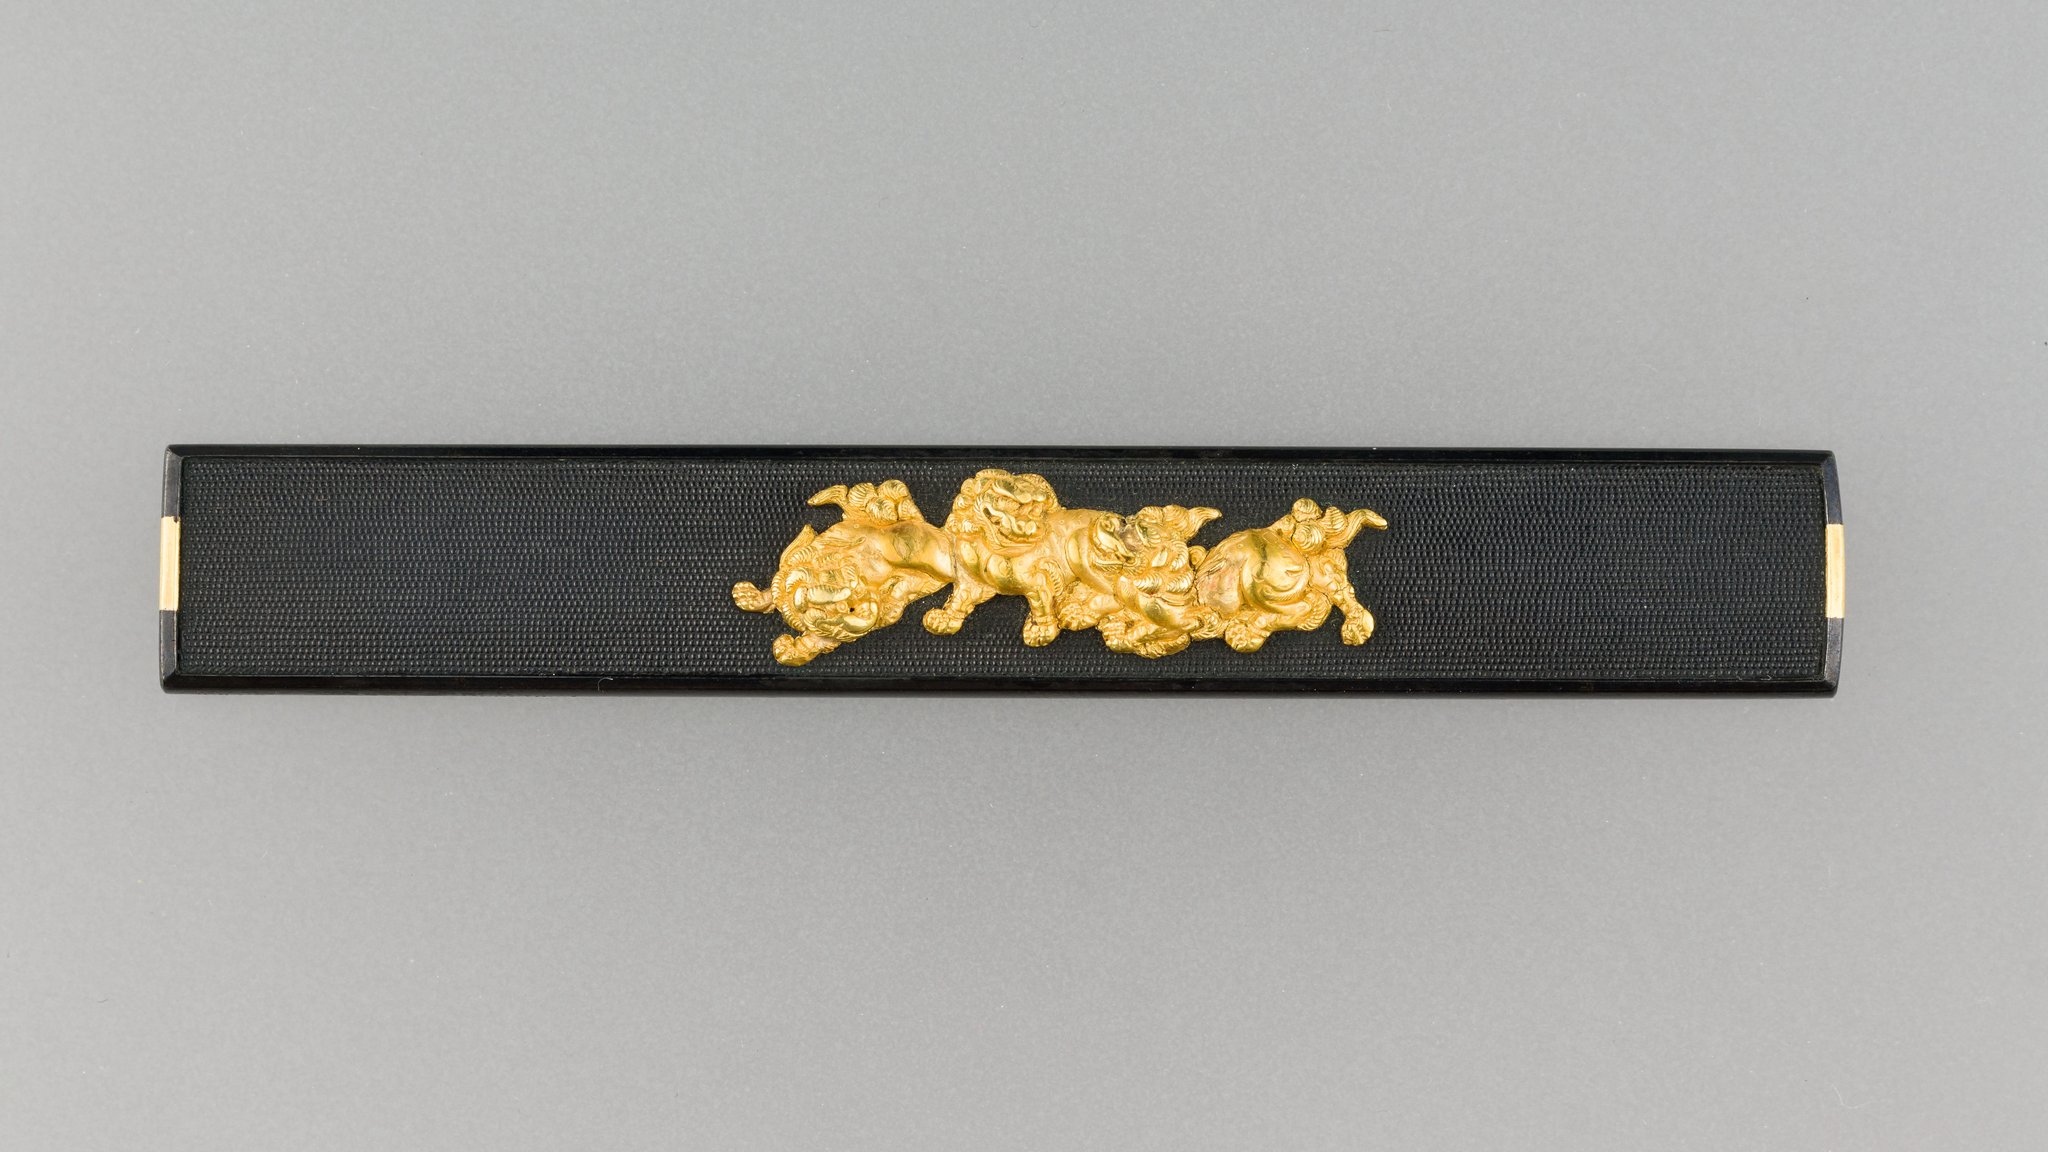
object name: knife handle kozuka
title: Knife Handle (Kozuka)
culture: japanese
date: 1434-1533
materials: gold alloy, gold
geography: japan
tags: lions